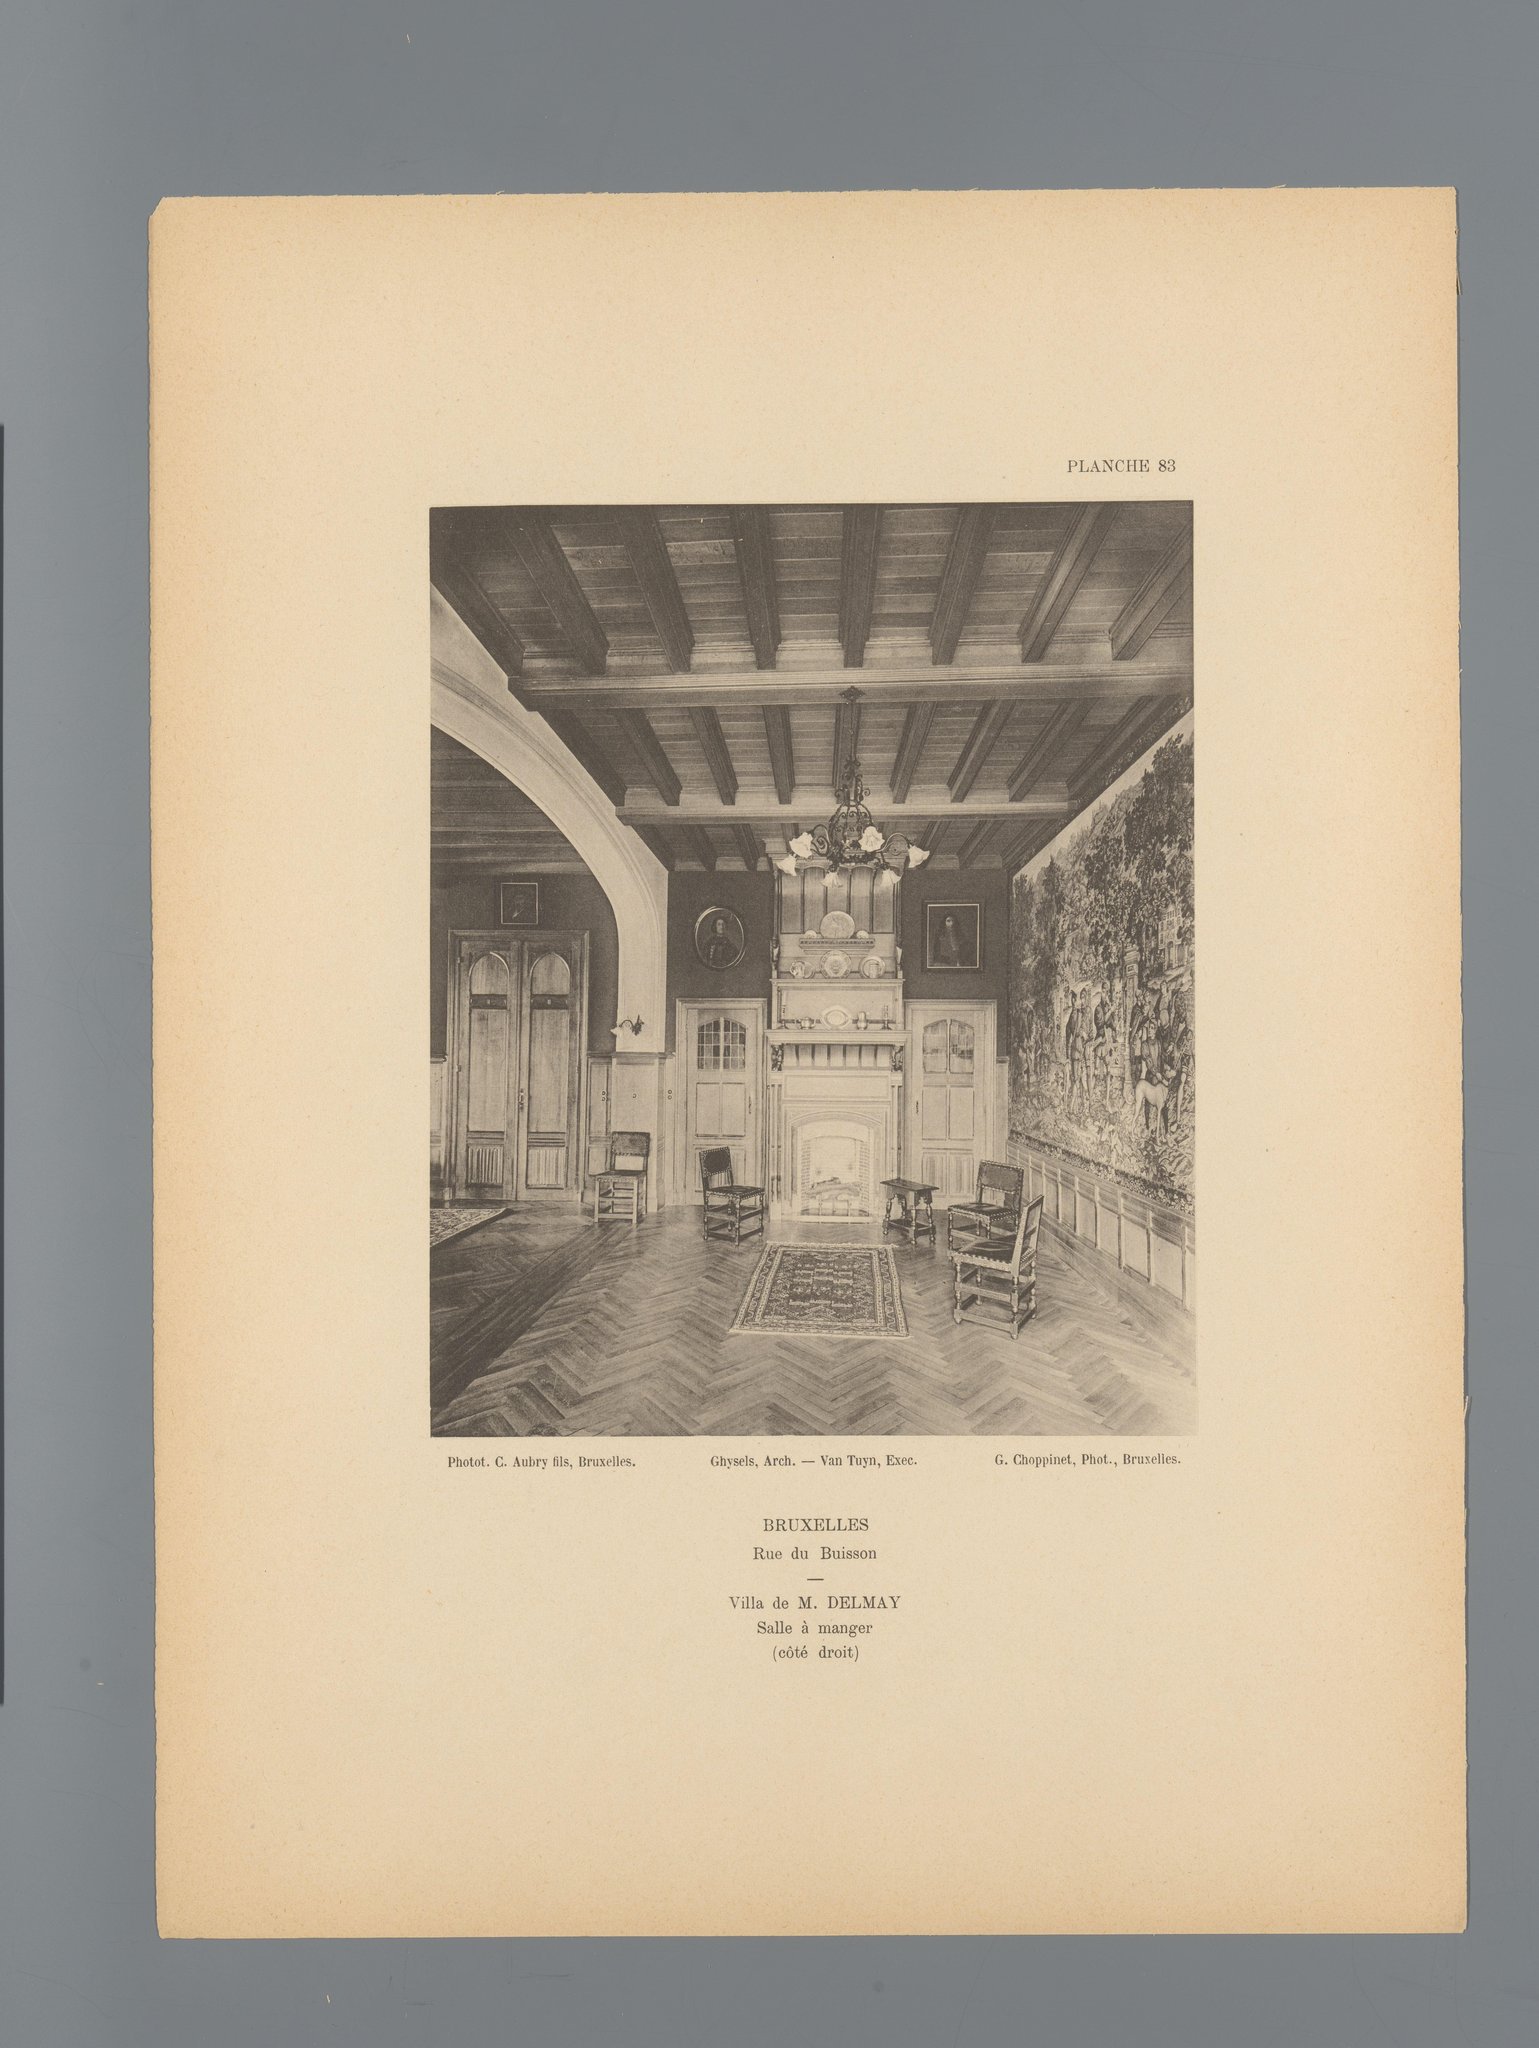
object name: photomechanical print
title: Gezicht op de eetzaal van het huis van Delmay in Brussel, België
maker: gustave choppinet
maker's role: fotograaf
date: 1893-1898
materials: paper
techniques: photograph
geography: brussels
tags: dining-room, brussels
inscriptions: number: ‘PLANCHE 83’, name: ‘Ghysels, Arch. - Van Tuyn, Exec.’, inscription: ‘Rue de Buisson/ Villa de M. DELMAY/ Salle à manger/ (côté droit)’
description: Deze prent maakt deel uit van een omslag met 89 prenten en 5 tekstbladen.